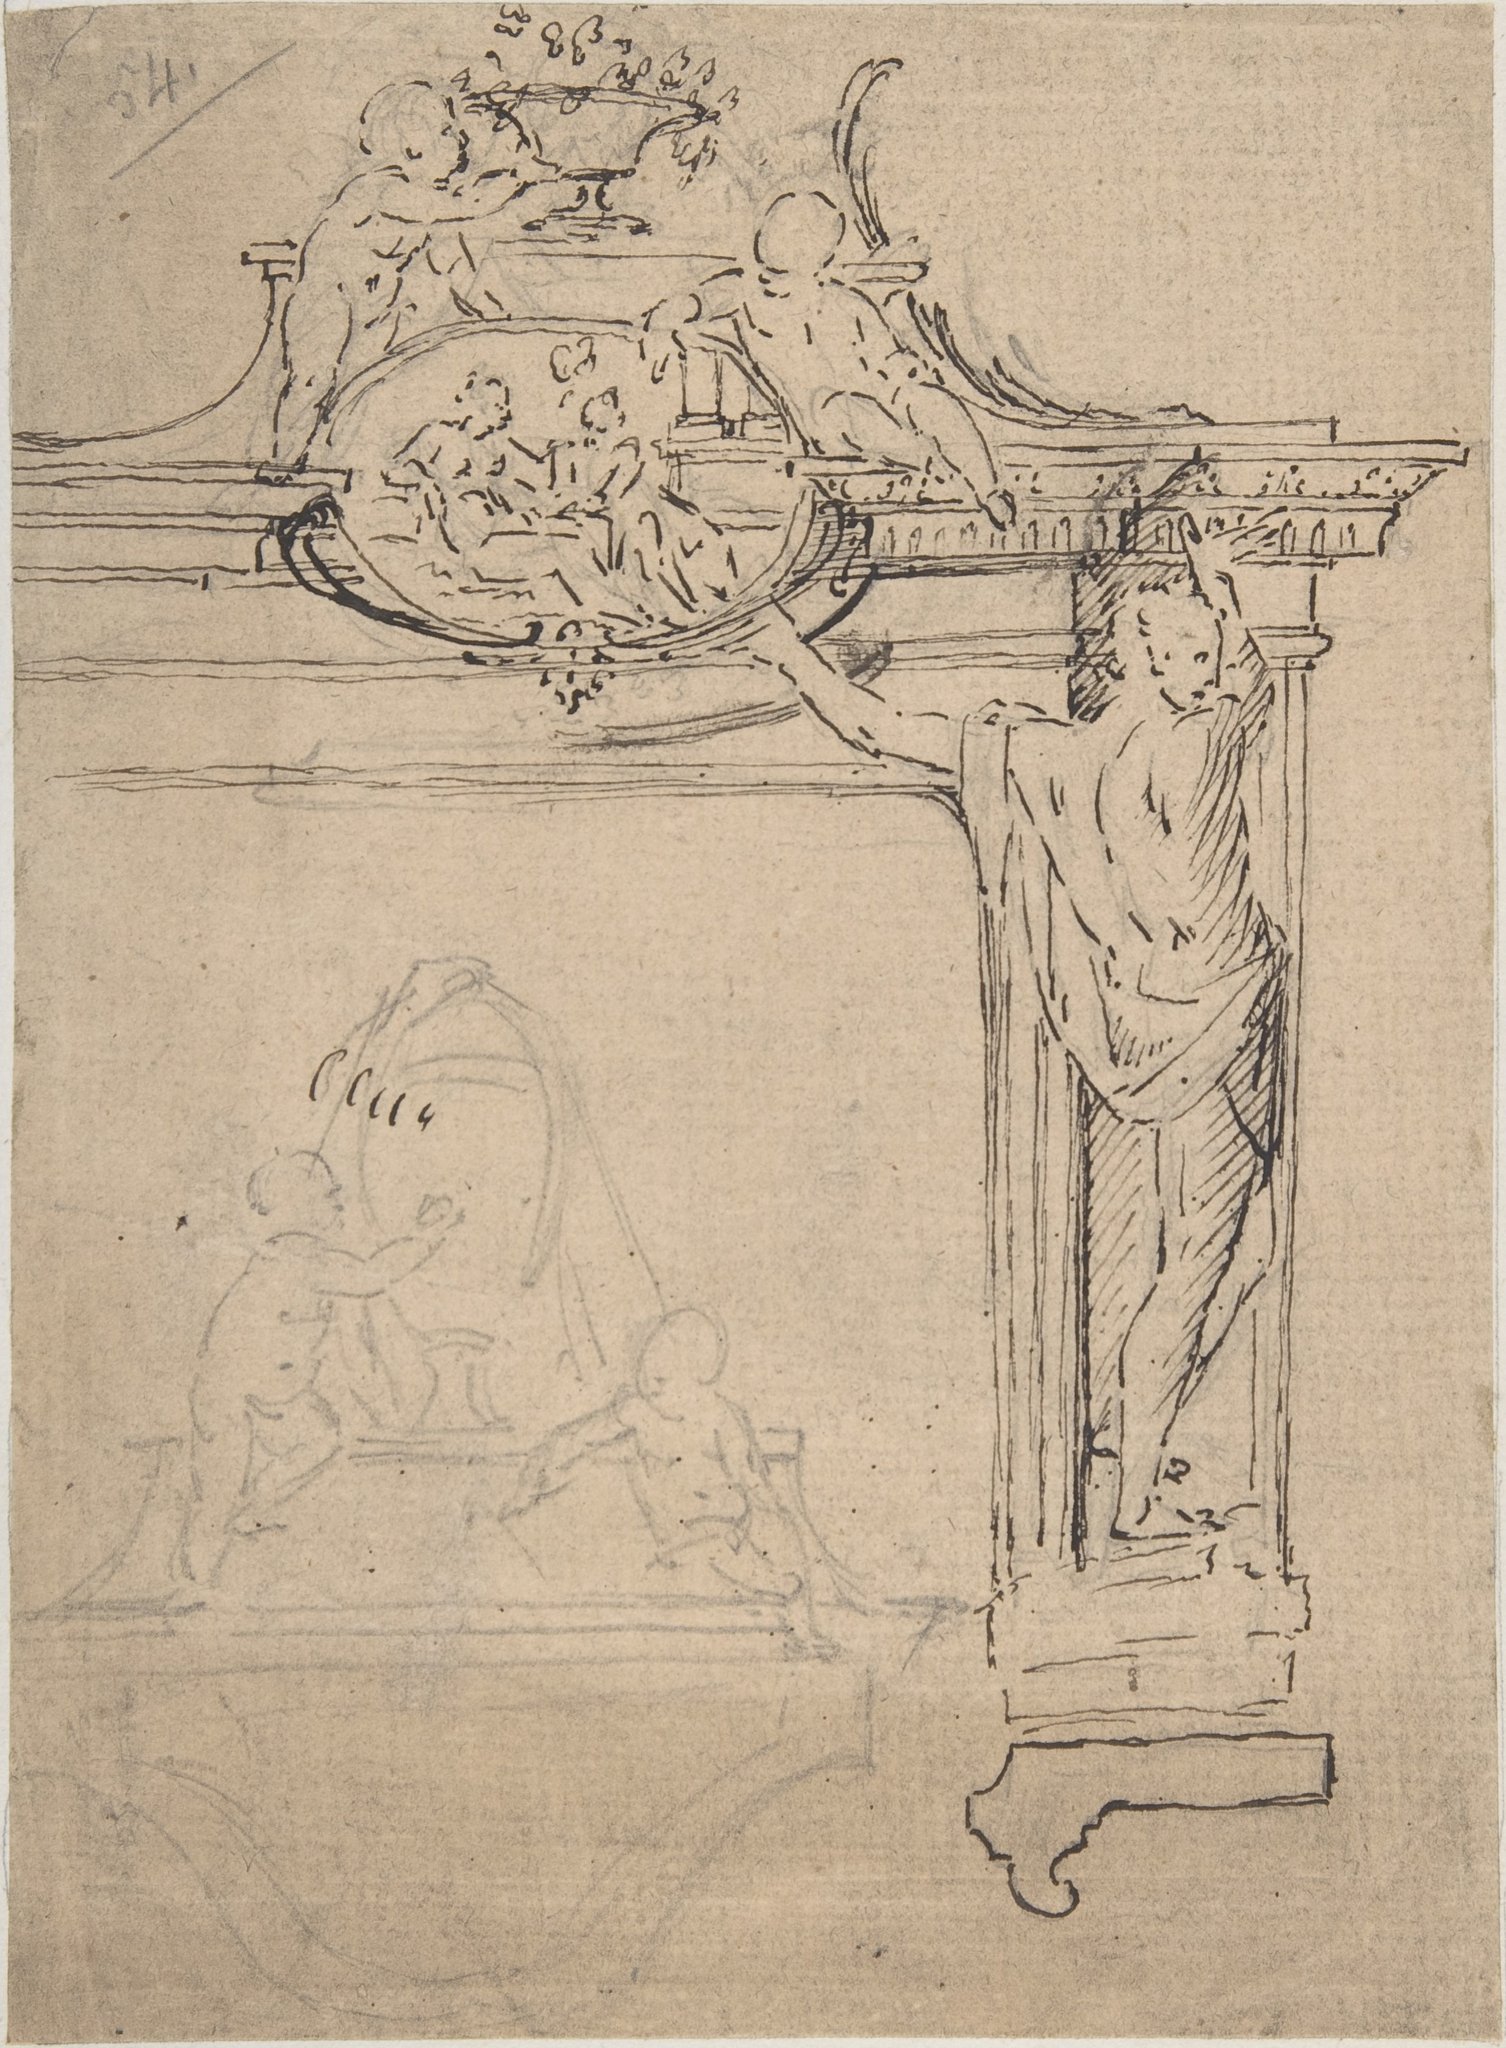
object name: ornament architecture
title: Framing Element with Figures (?)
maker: anonymous, italian, 17th century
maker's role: artist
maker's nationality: italian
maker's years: 1600-1700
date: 1601-1700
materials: graphite, ink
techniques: pen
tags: ornament